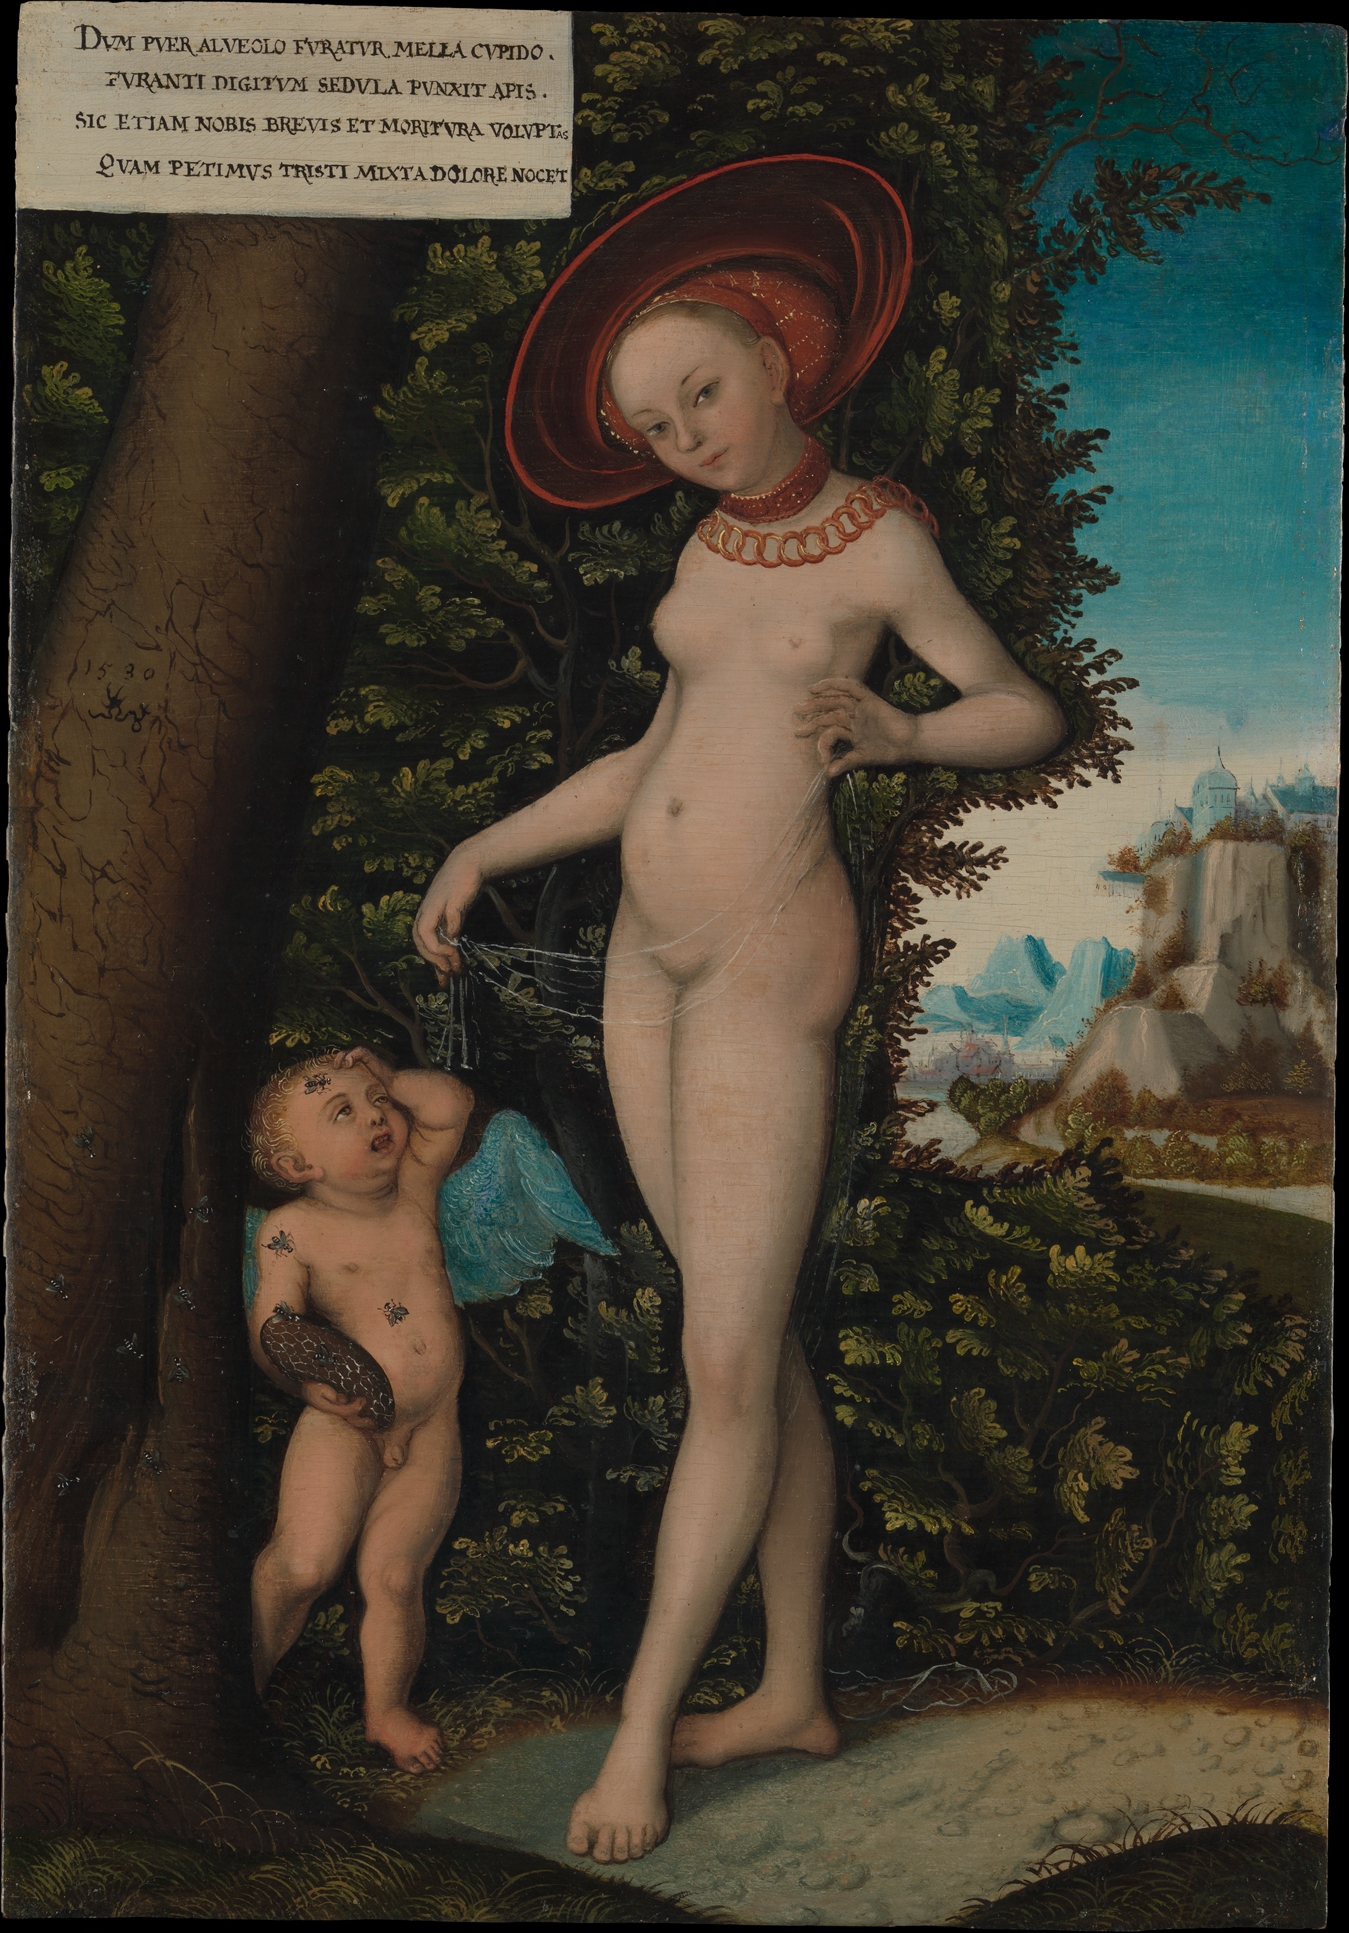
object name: painting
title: Venus with Cupid the Honey Thief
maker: lucas cranach the elder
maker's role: artist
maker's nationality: german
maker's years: 1472-1553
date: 1580-1620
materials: wood, oil, panel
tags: cupid,venus,bees